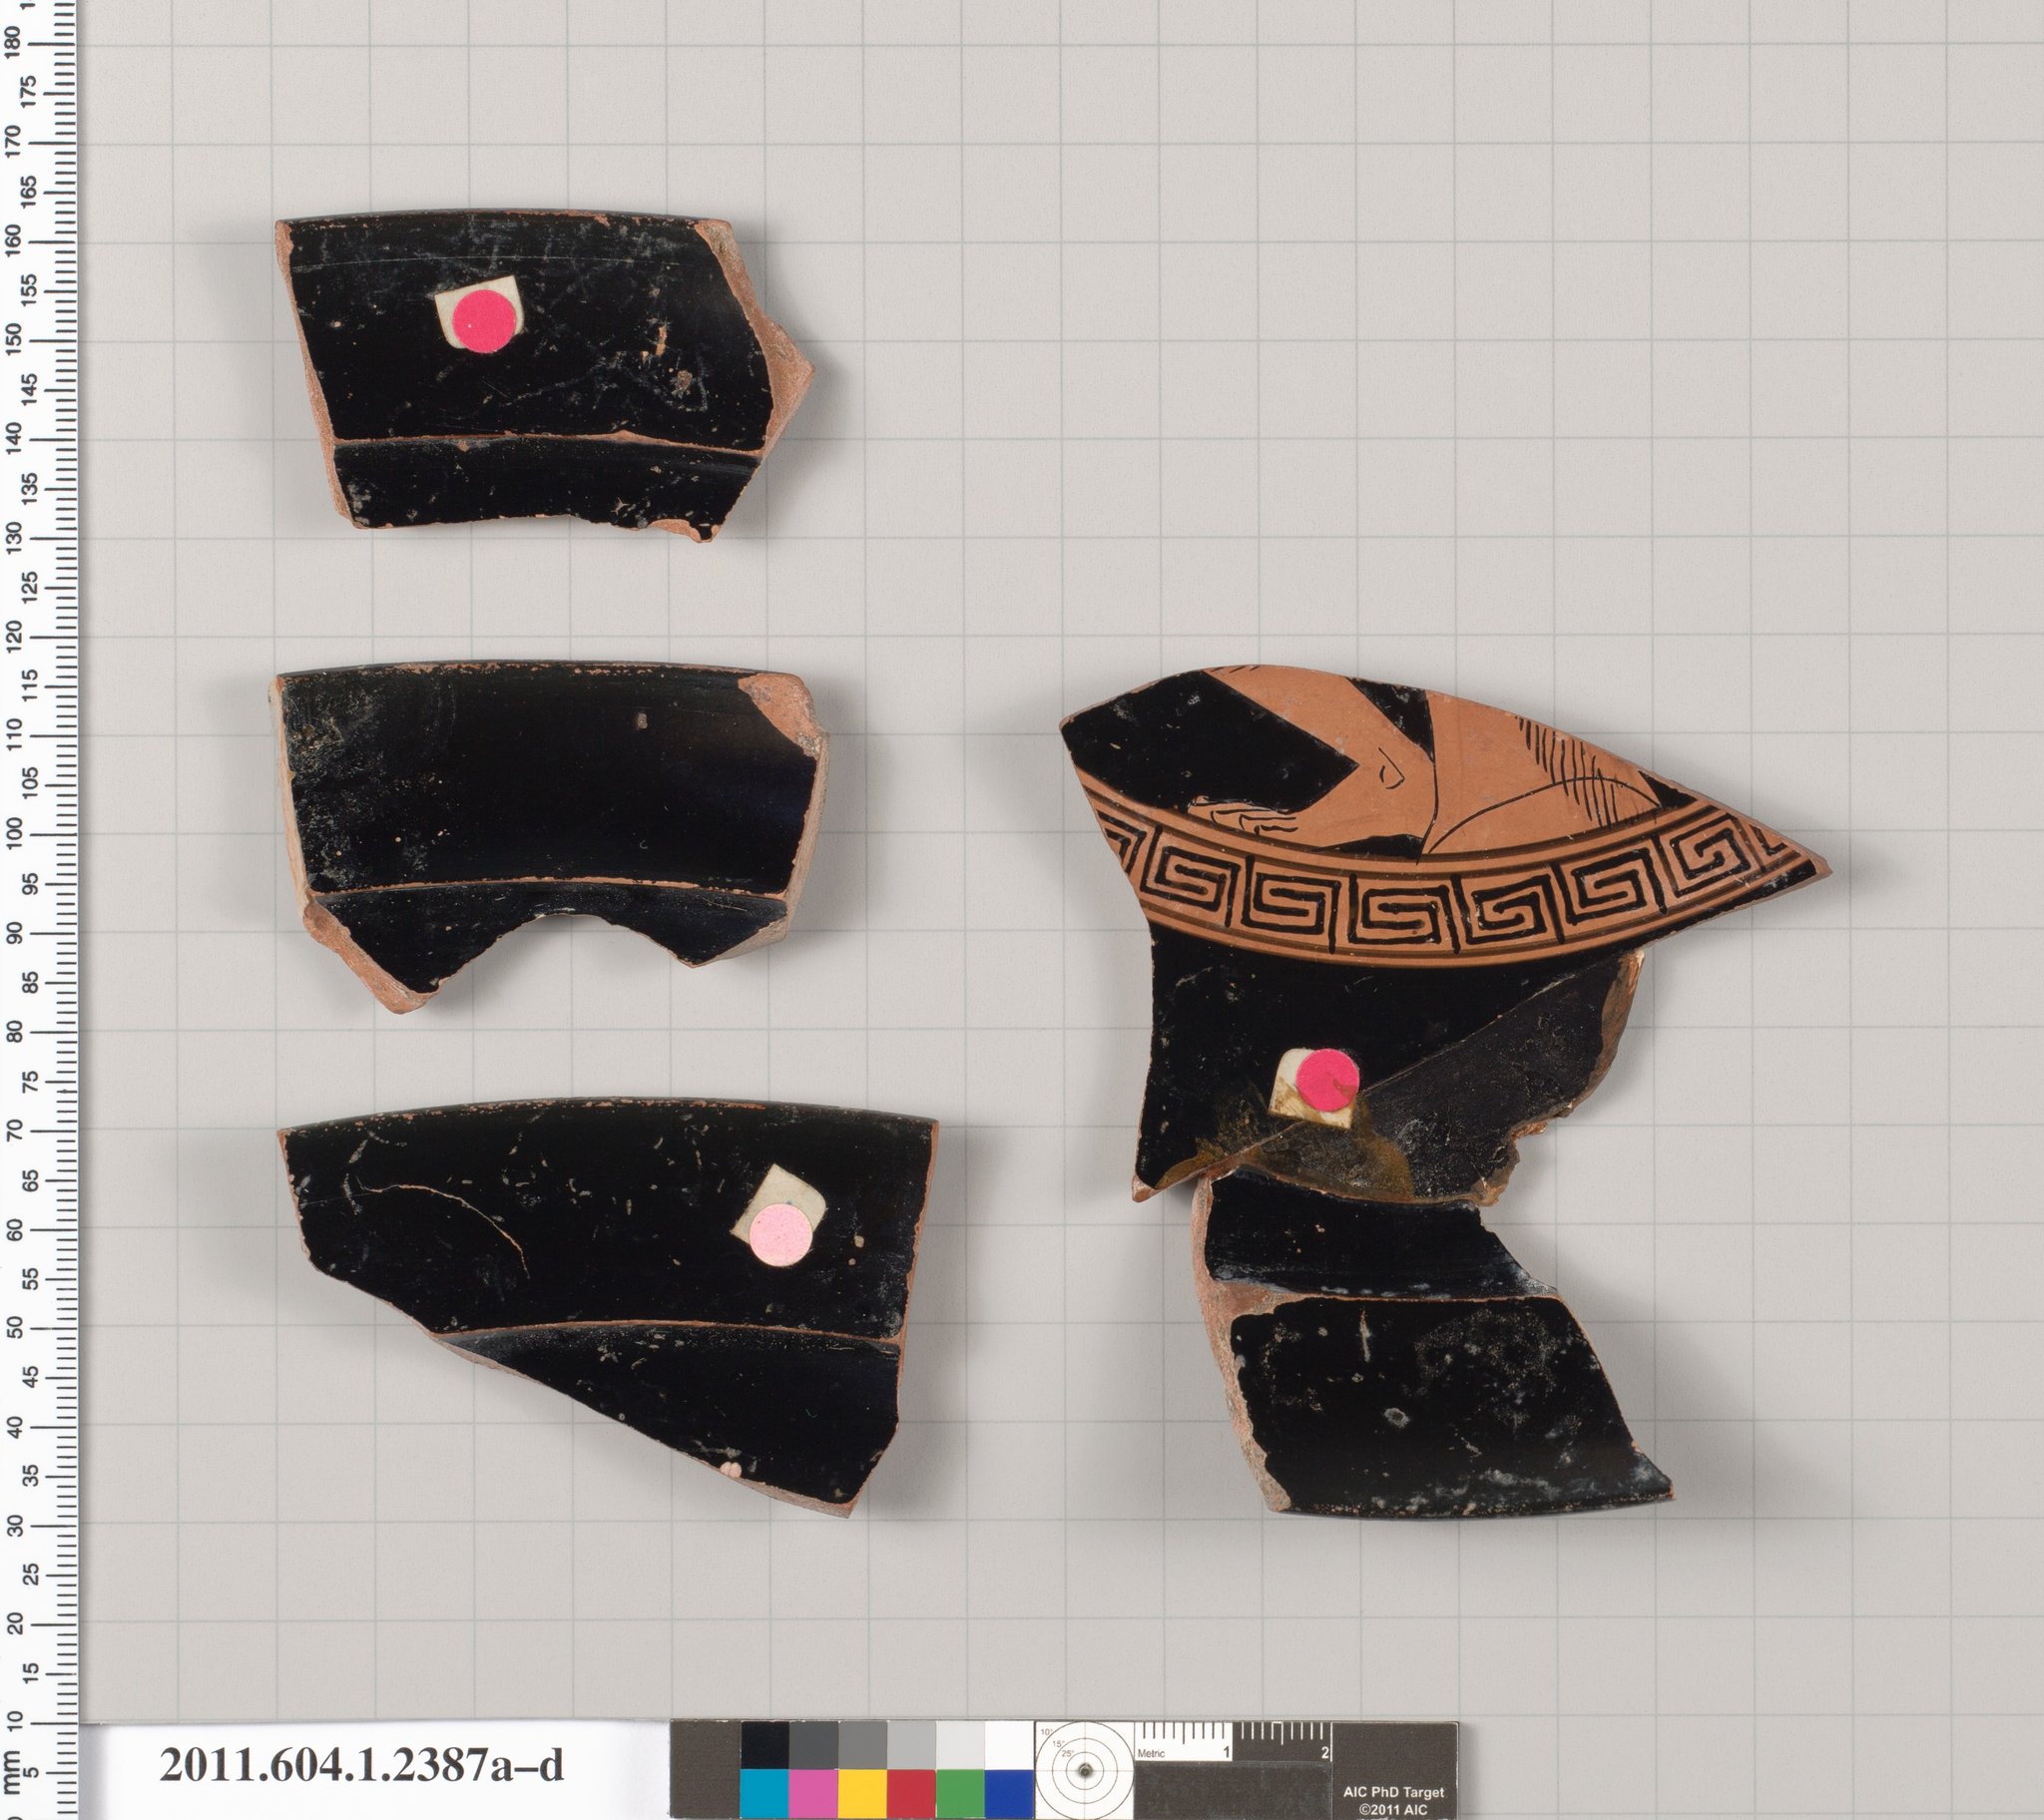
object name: kylix fragment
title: Terracotta rim fragments of a kylix (drinking cup)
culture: greek, attic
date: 520-500 BCE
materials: terracotta